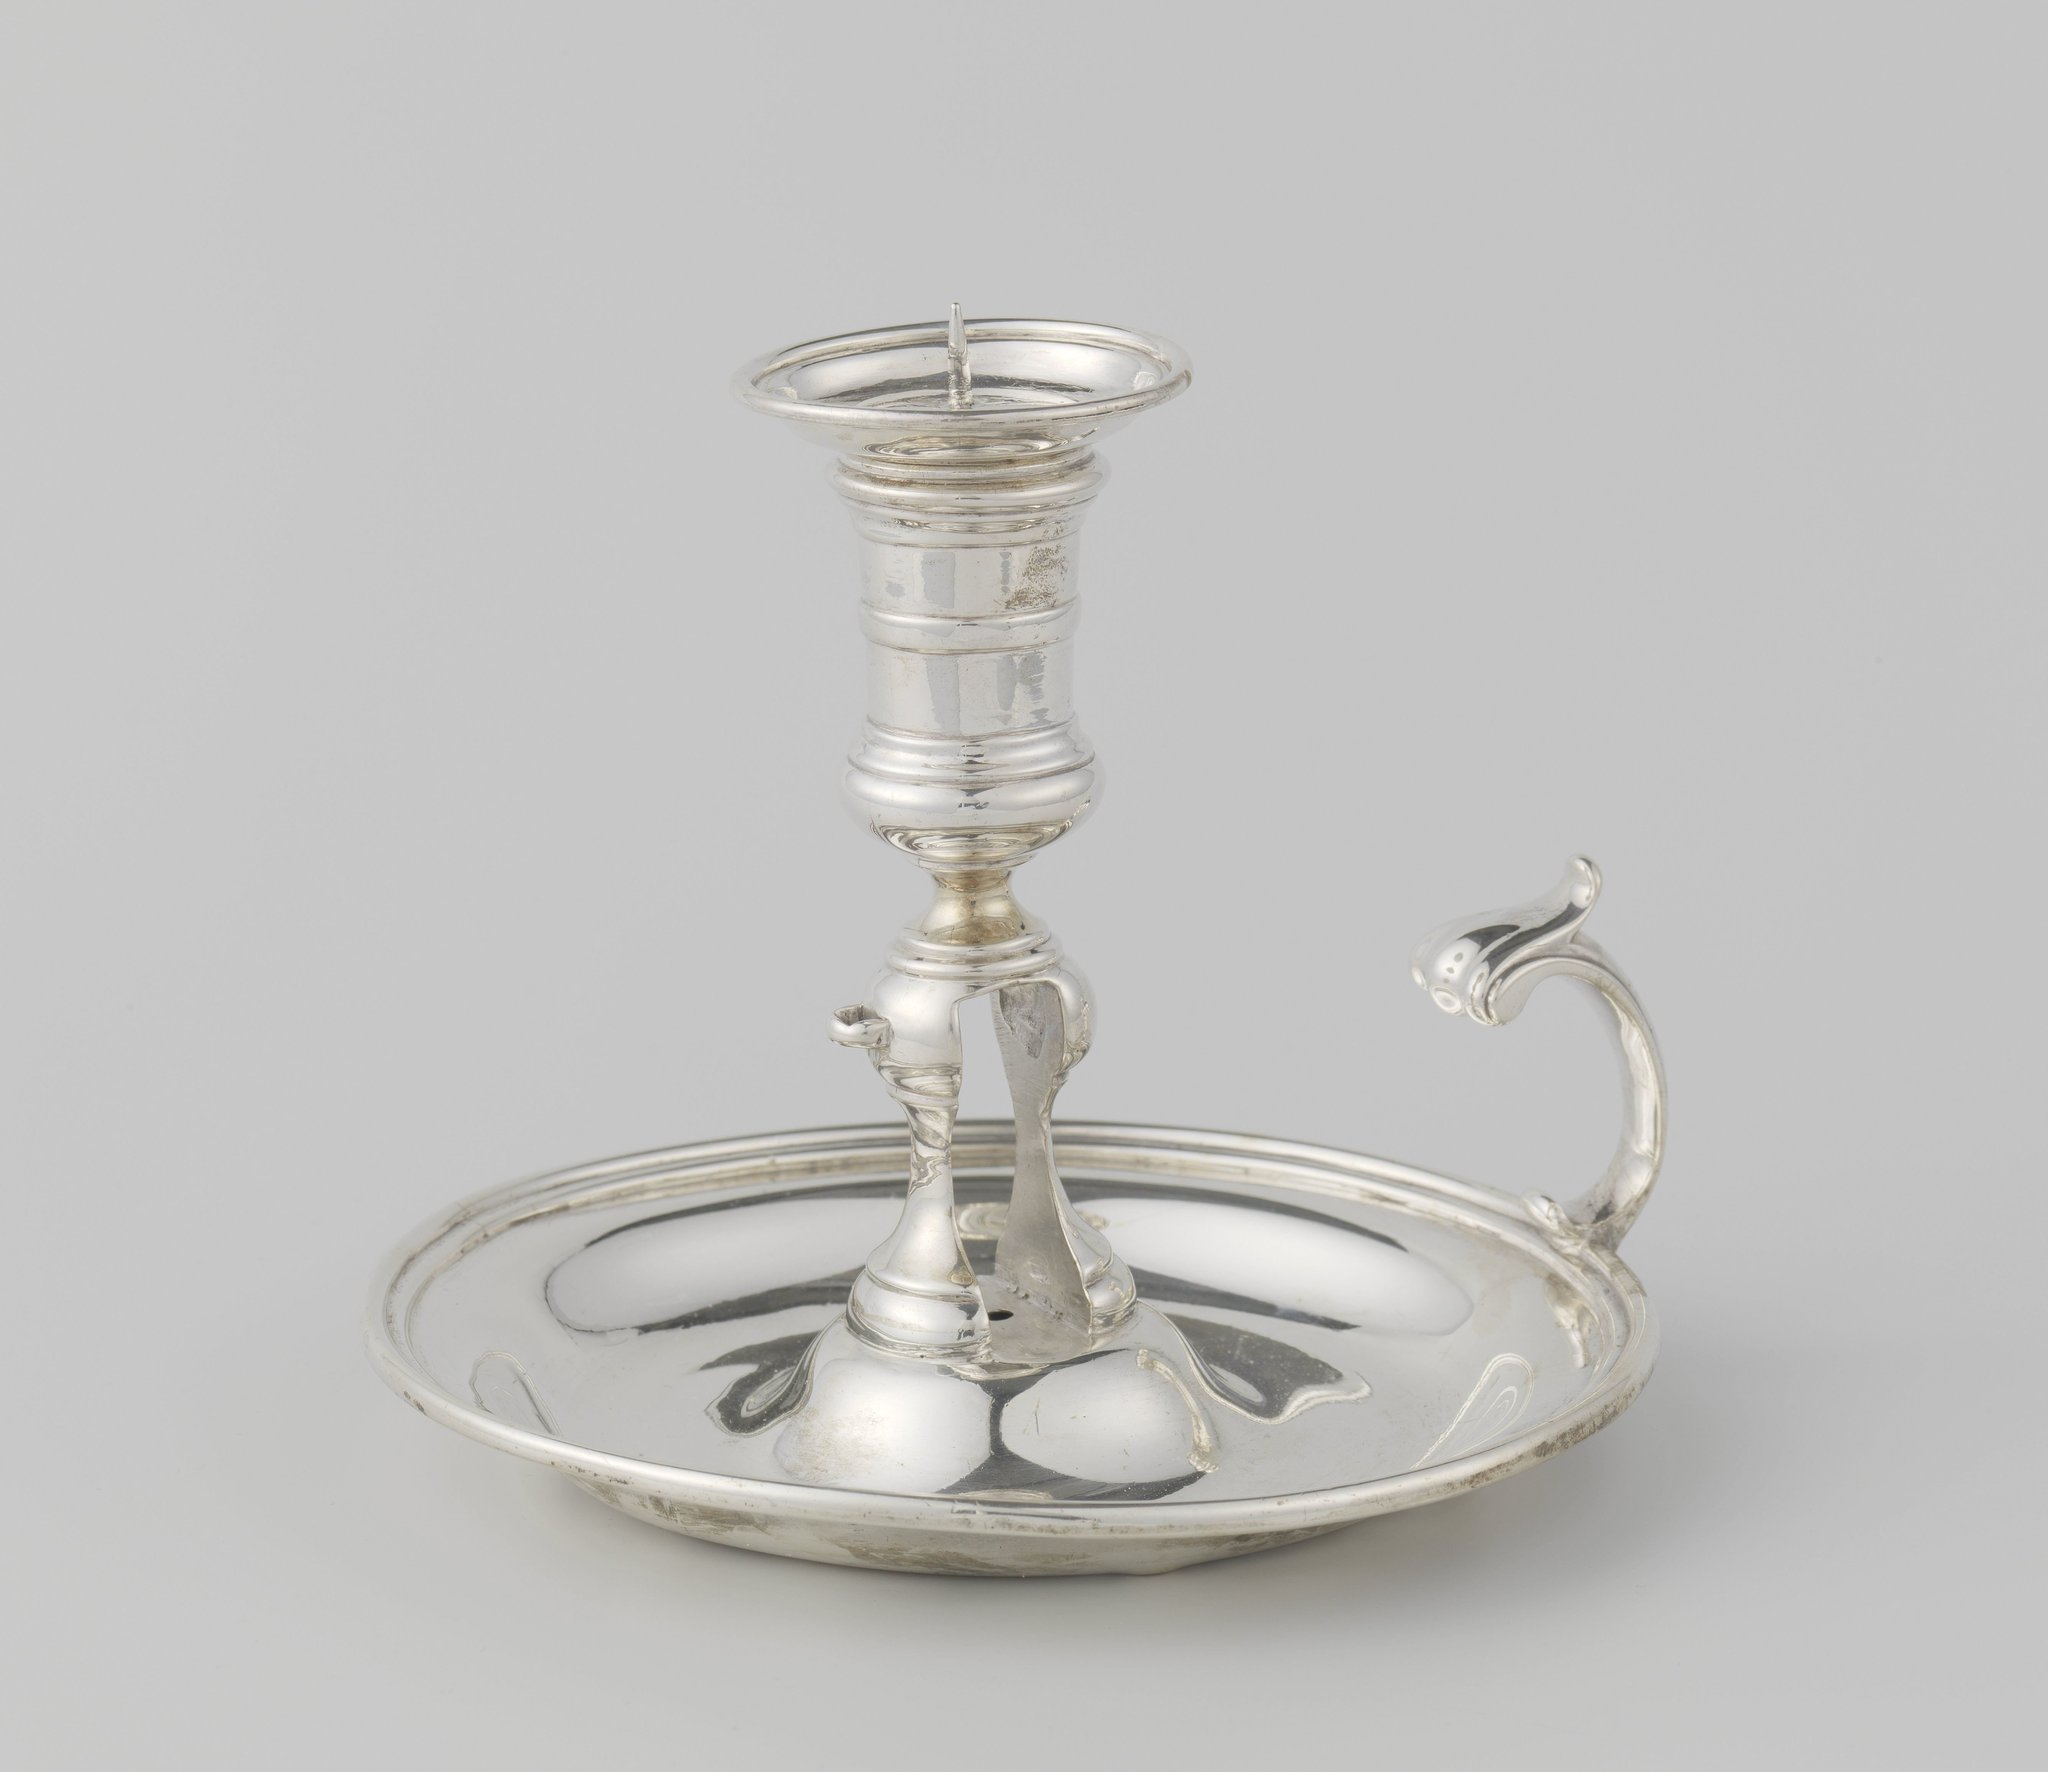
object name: chamberstick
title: Blaker van zilver, op korte stam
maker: Anonymous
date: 1748-1749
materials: silver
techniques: casting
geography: the hague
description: Chamberstick with extinguisher and snuffers. Silver. The Hague, 1748, by Reynier de Haan.